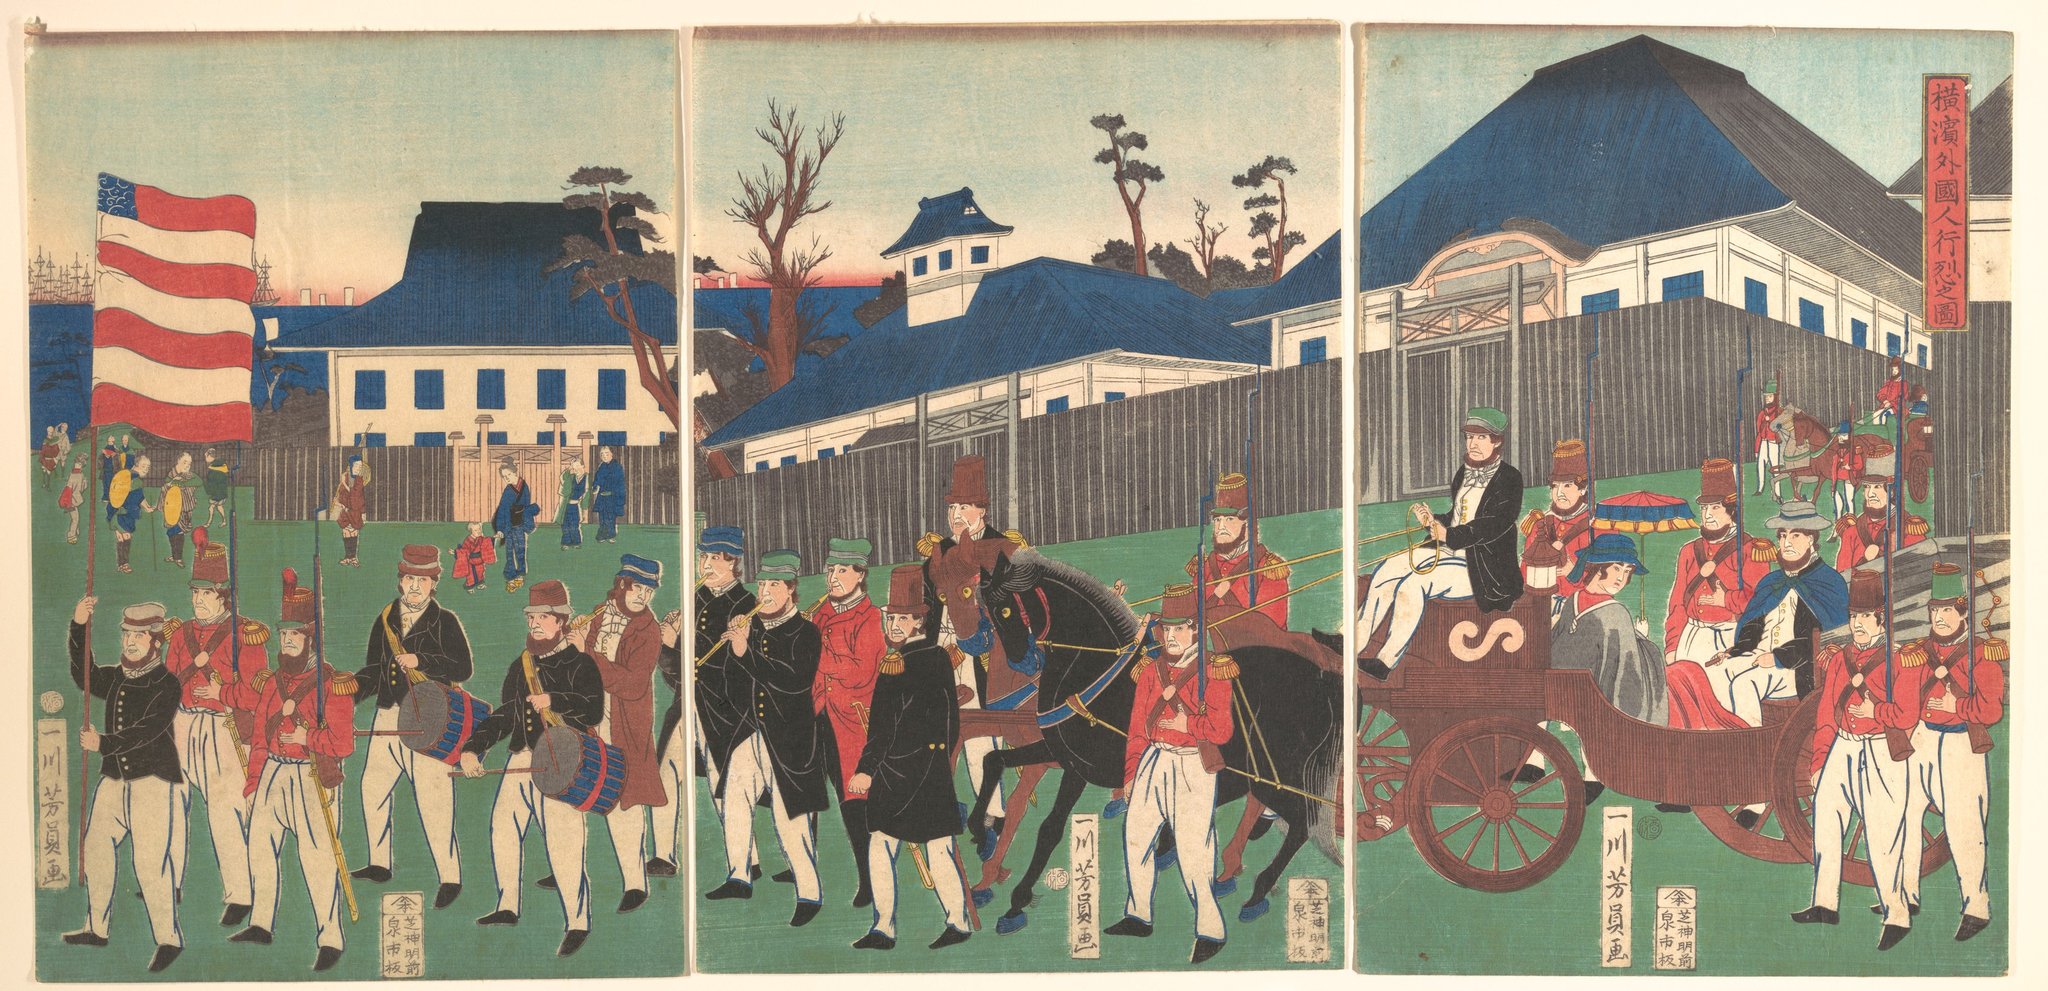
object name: print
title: Picture of a Procession of Foreigners at Yokohama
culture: japanese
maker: utagawa yoshikazu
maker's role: artist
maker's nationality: japanese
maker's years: 1845-1870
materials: ink, paper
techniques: woodblock print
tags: houses,men,flags,carriages